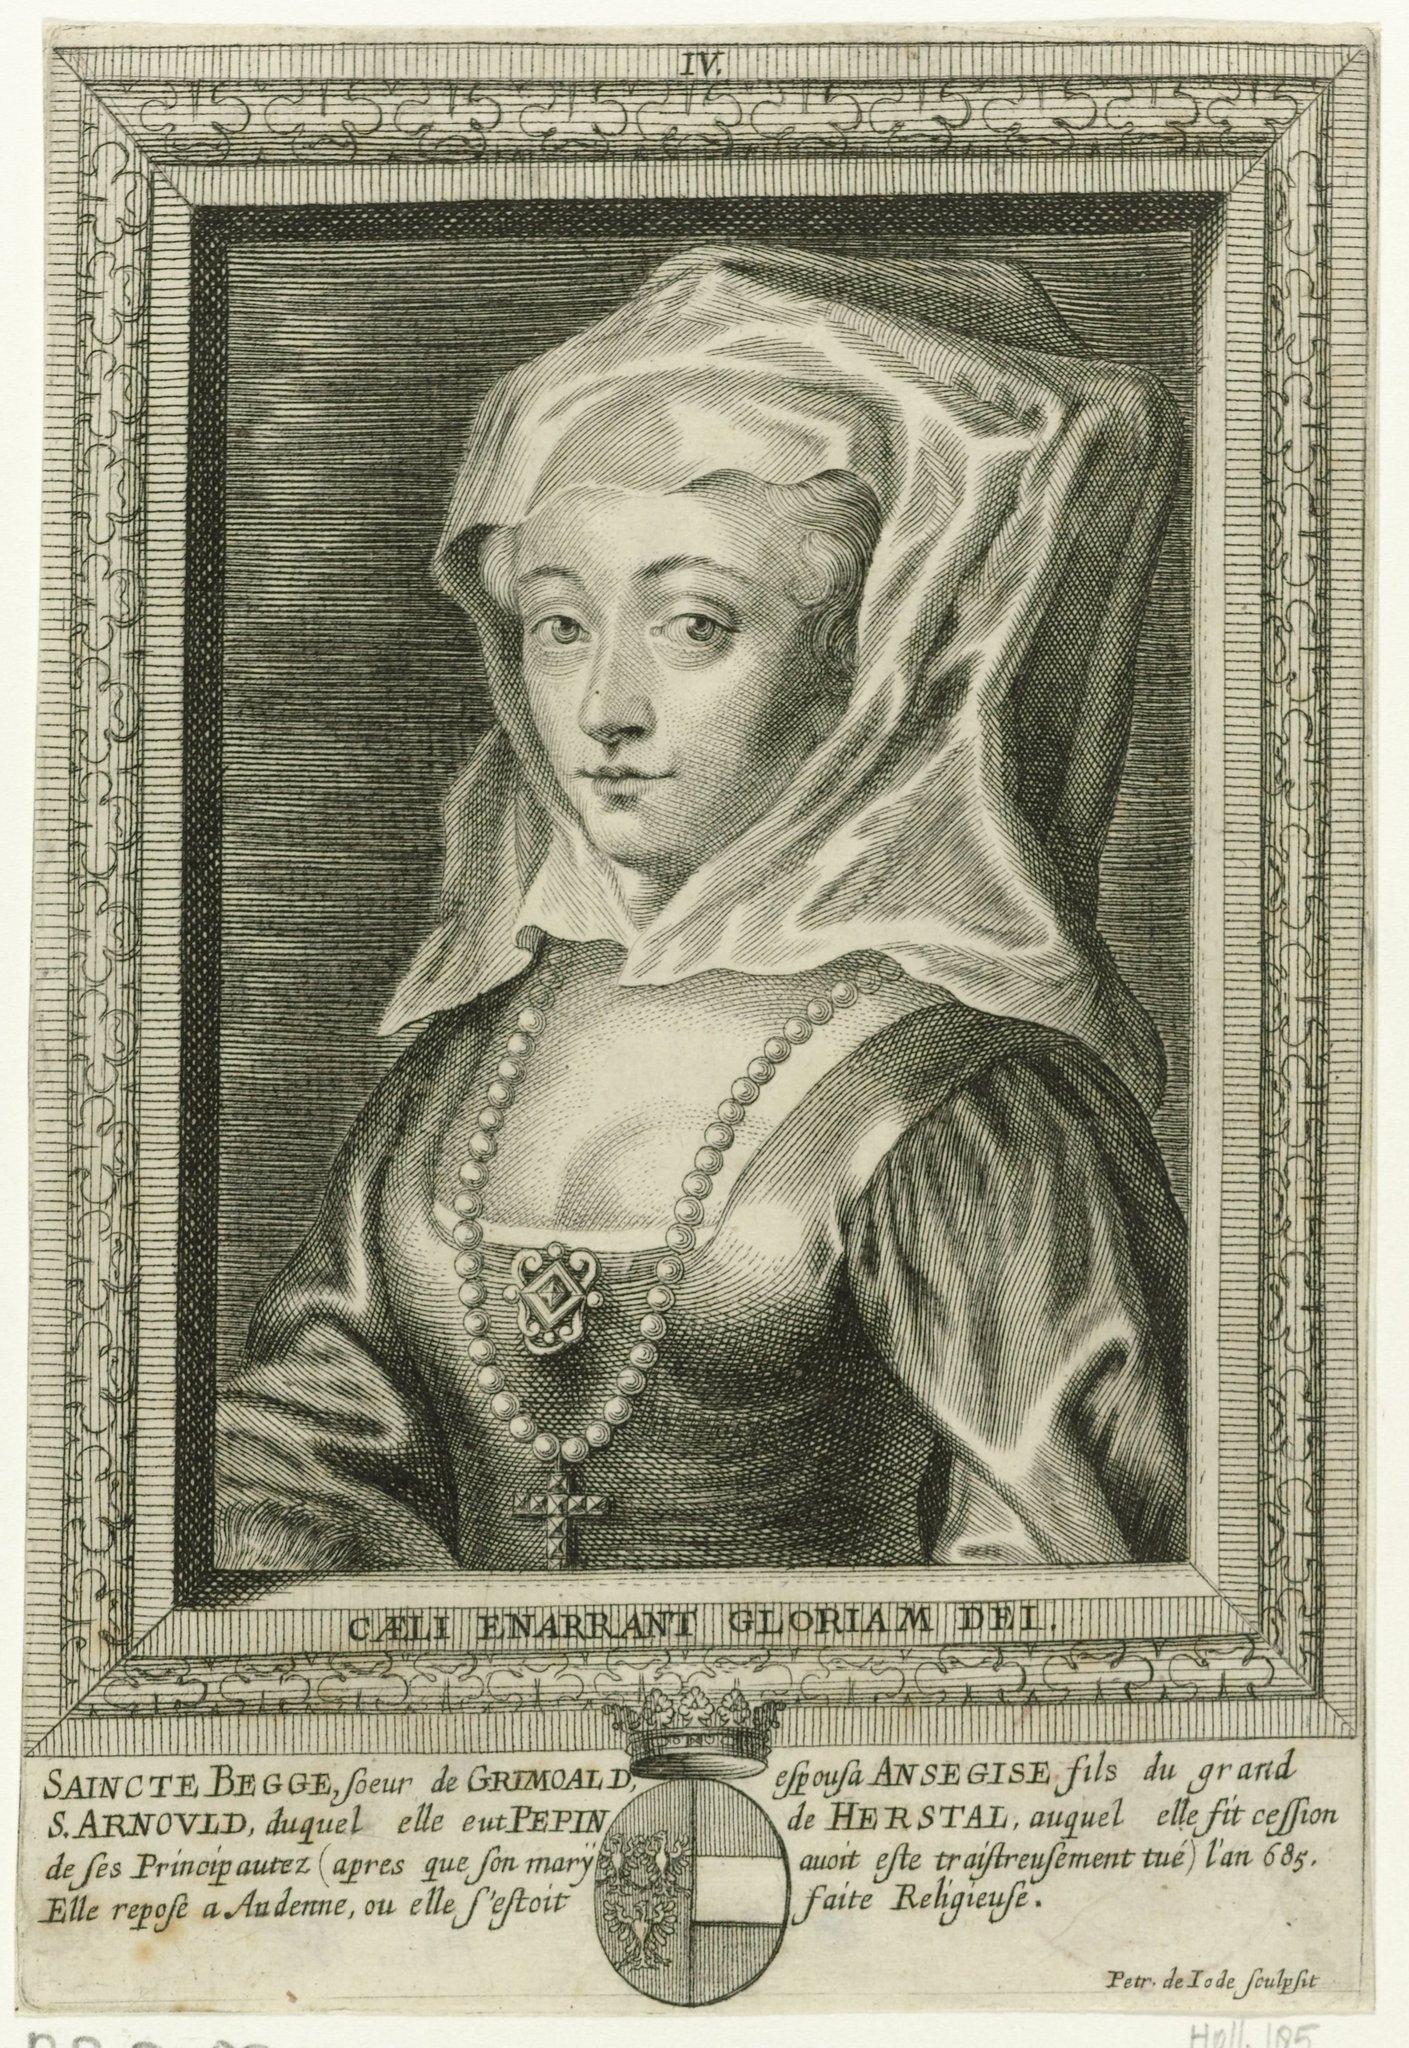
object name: print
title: Portret van Begge van Andenne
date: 1661-1663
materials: paper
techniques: engraving, etching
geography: antwerp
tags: begge van andenne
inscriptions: collector's mark: Lugt 240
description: Busteportret van Begge van Andenne, met sluier. Het portret is gevat in een rechthoekige omlijsting met een motto in het Latijn. In de marge het wapenschild van de geportretteerde en een vierregelig onderschrift in het Frans. Prent uit een boek waarin 54 prenten met portretten.